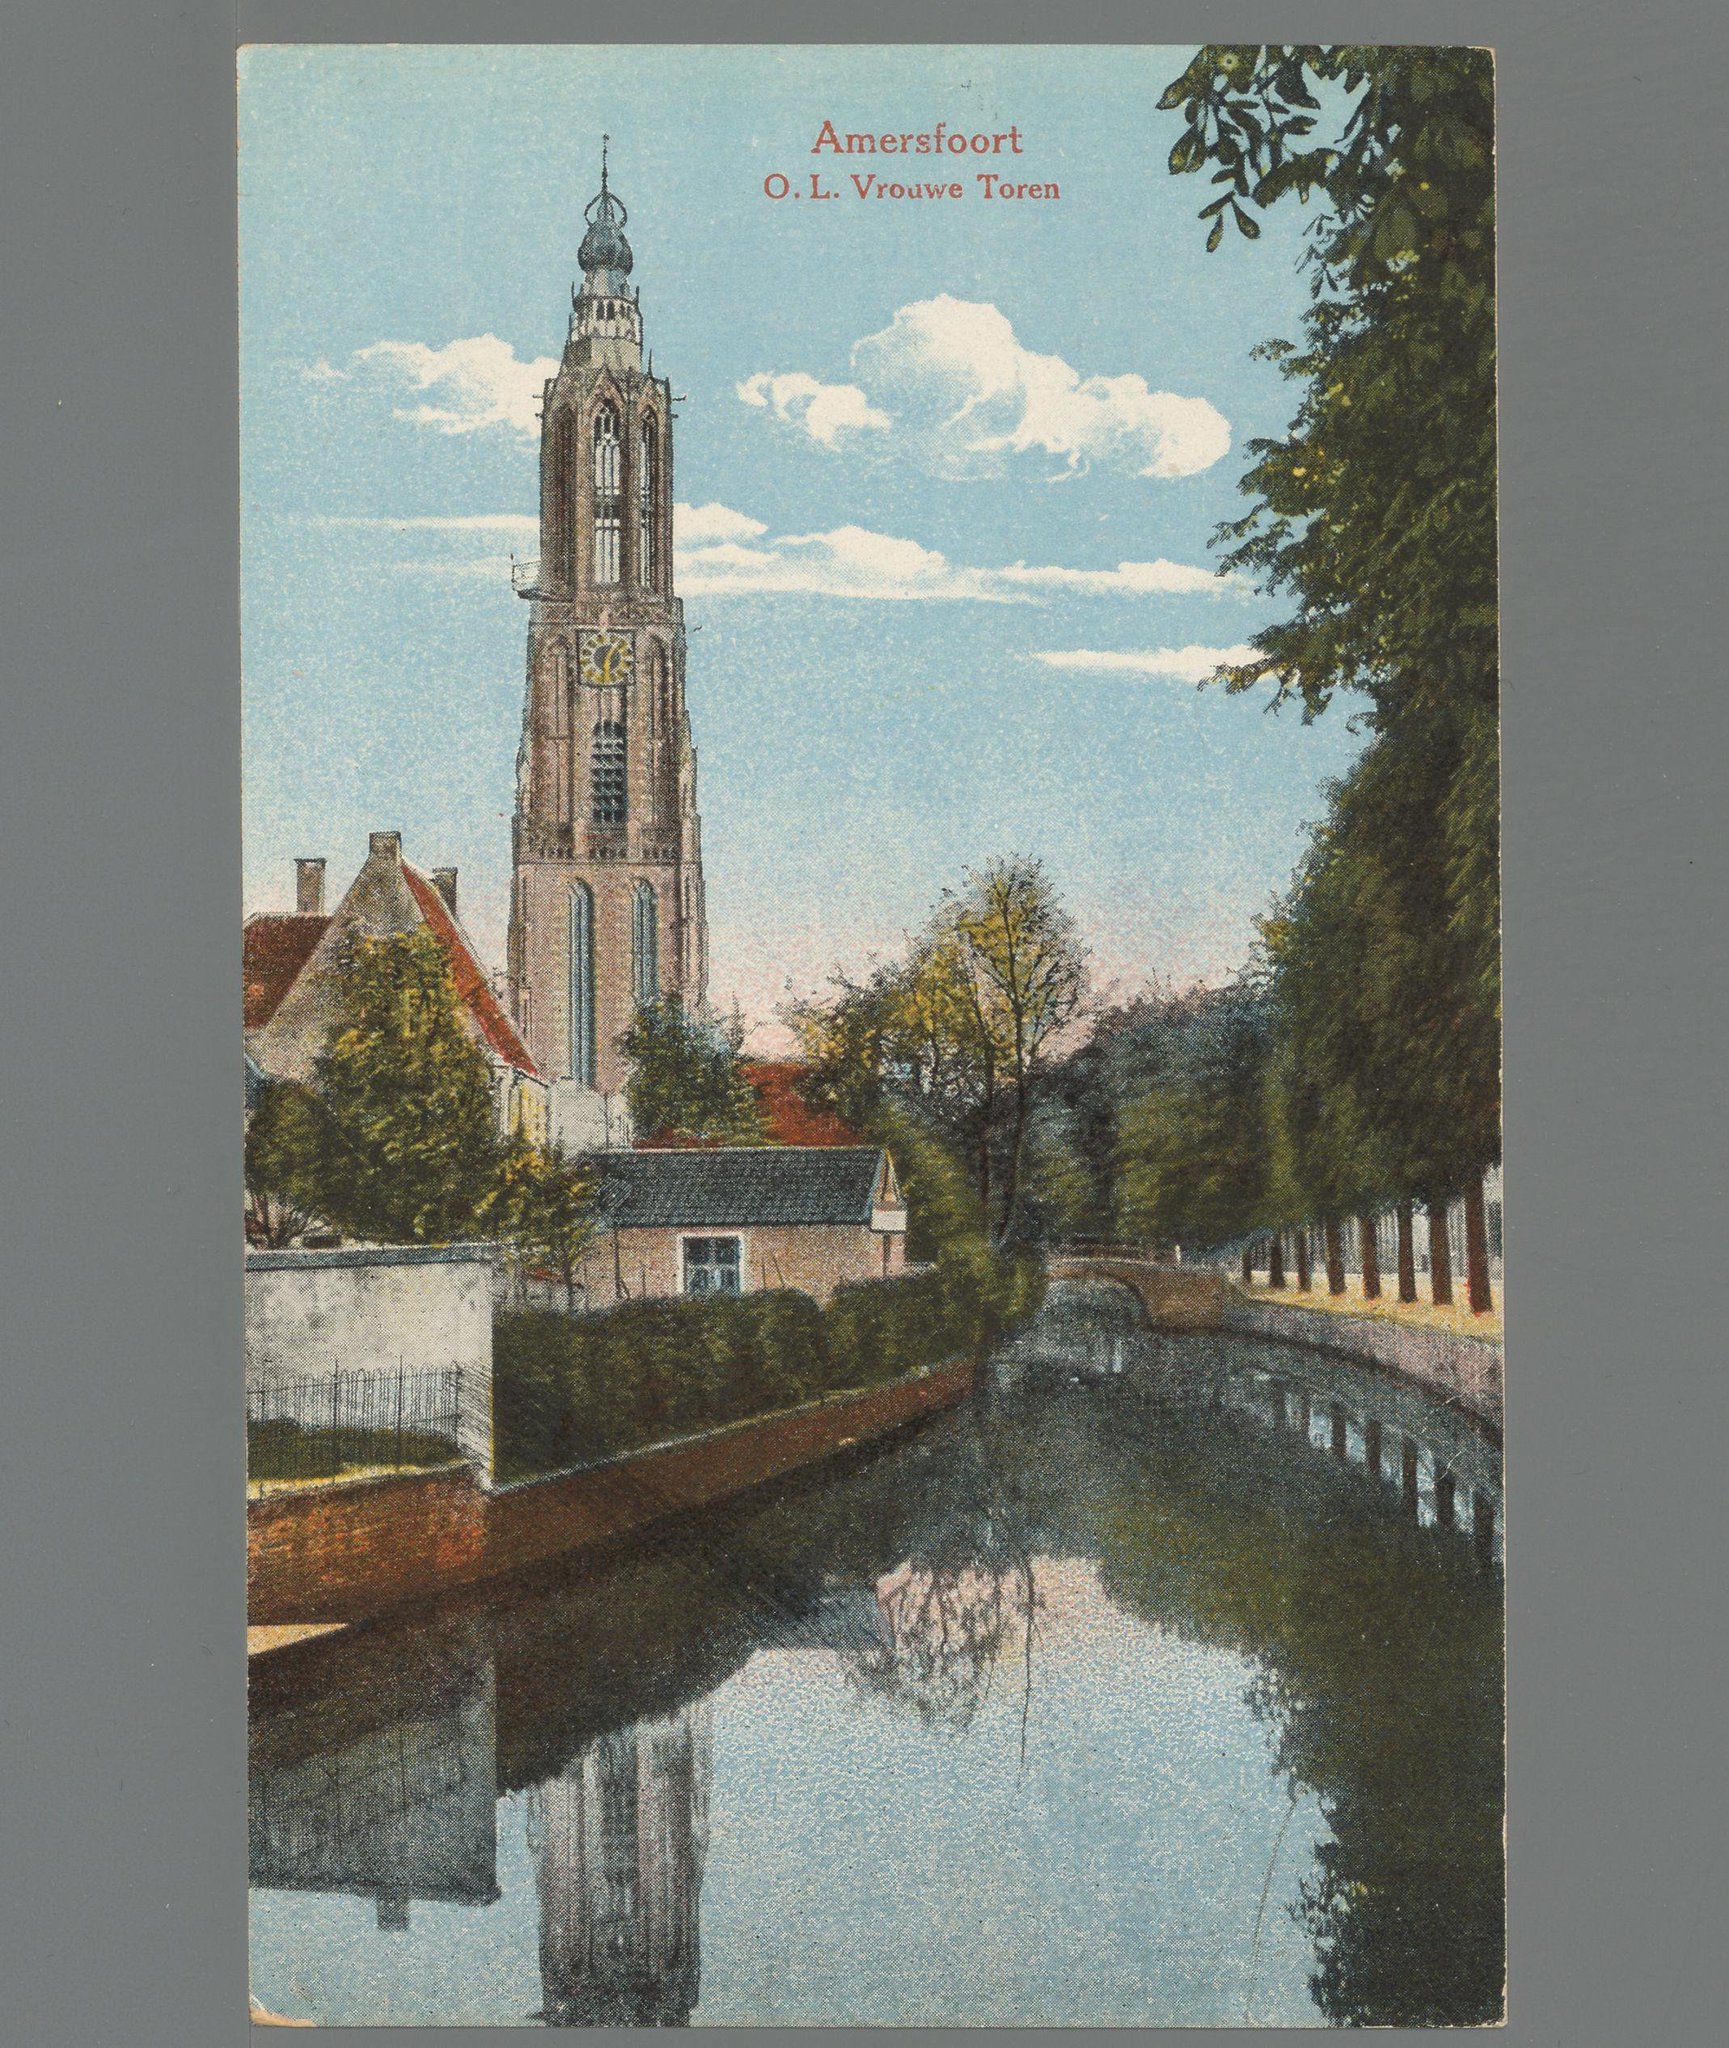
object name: photomechanical print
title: Amersfoort. O.L. Vrouwe Toren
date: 1905-1930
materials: cardboard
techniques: lithograph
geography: amersfoort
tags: church (exterior), canals, waters (in city)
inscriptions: monogram: ‘G.B.’